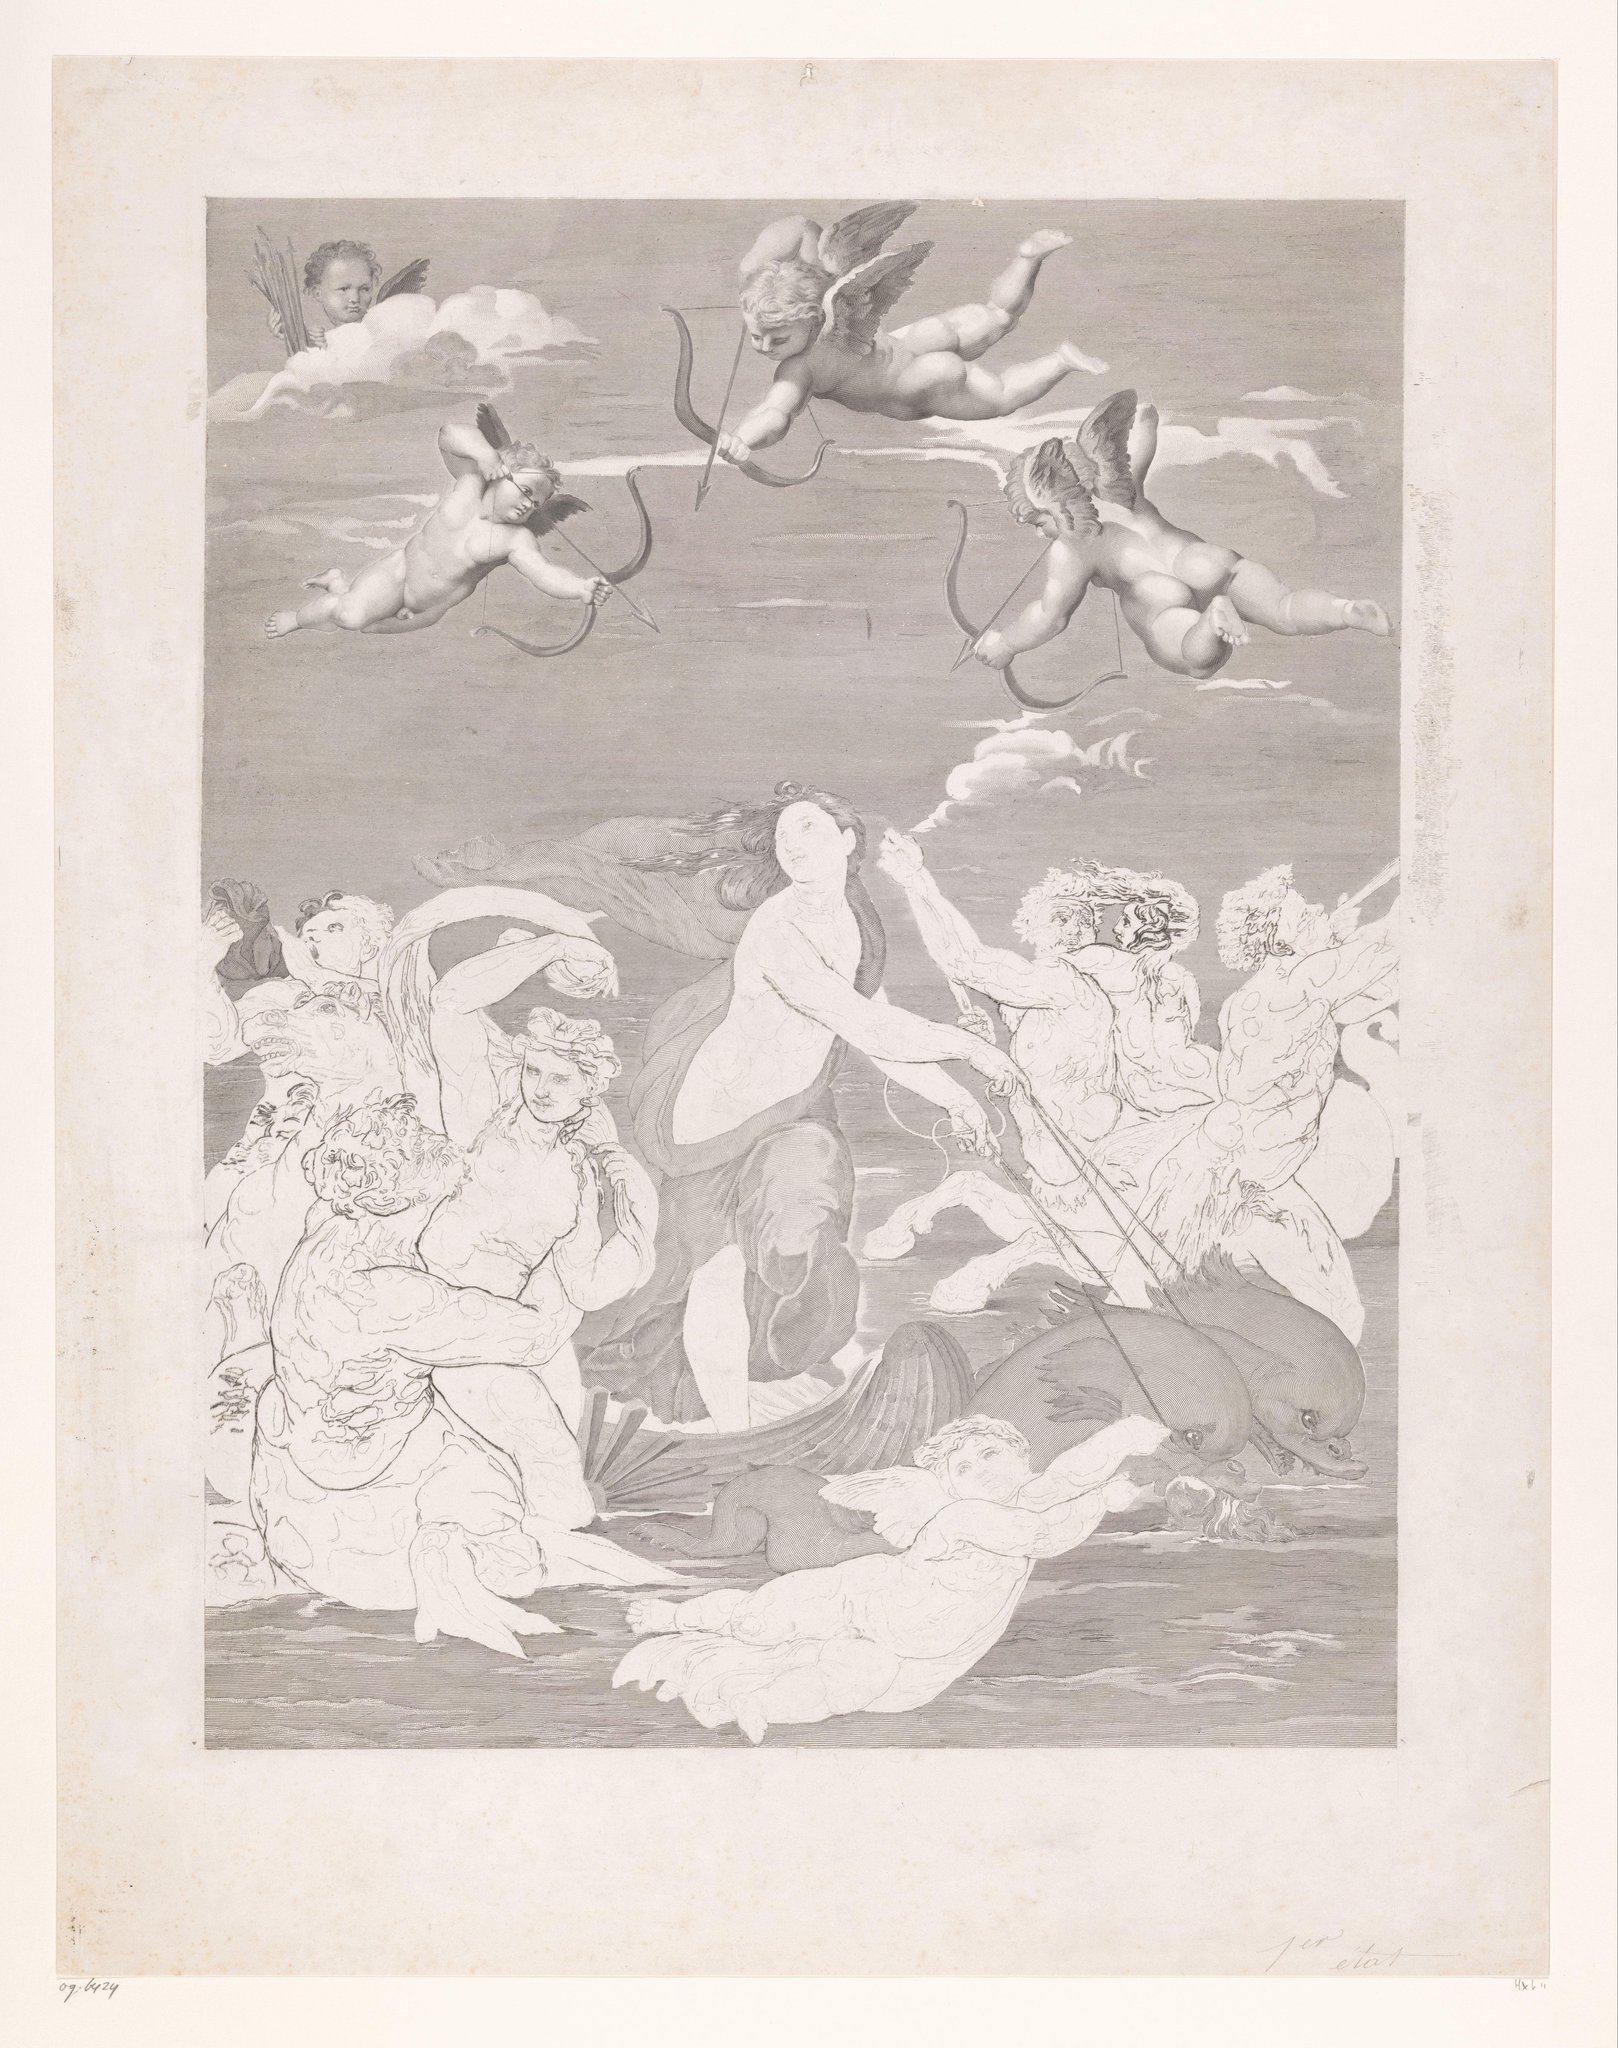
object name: print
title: Triomf van Galathea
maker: gustave joseph biot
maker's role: print maker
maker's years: 1833-1905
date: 1843-1905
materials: paper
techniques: engraving, etching, roulette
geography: belgium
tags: triumph of galatea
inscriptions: annotation: ‘15a/ 12/77 [in getekende driehoek]’, collector's mark: Lugt 2228